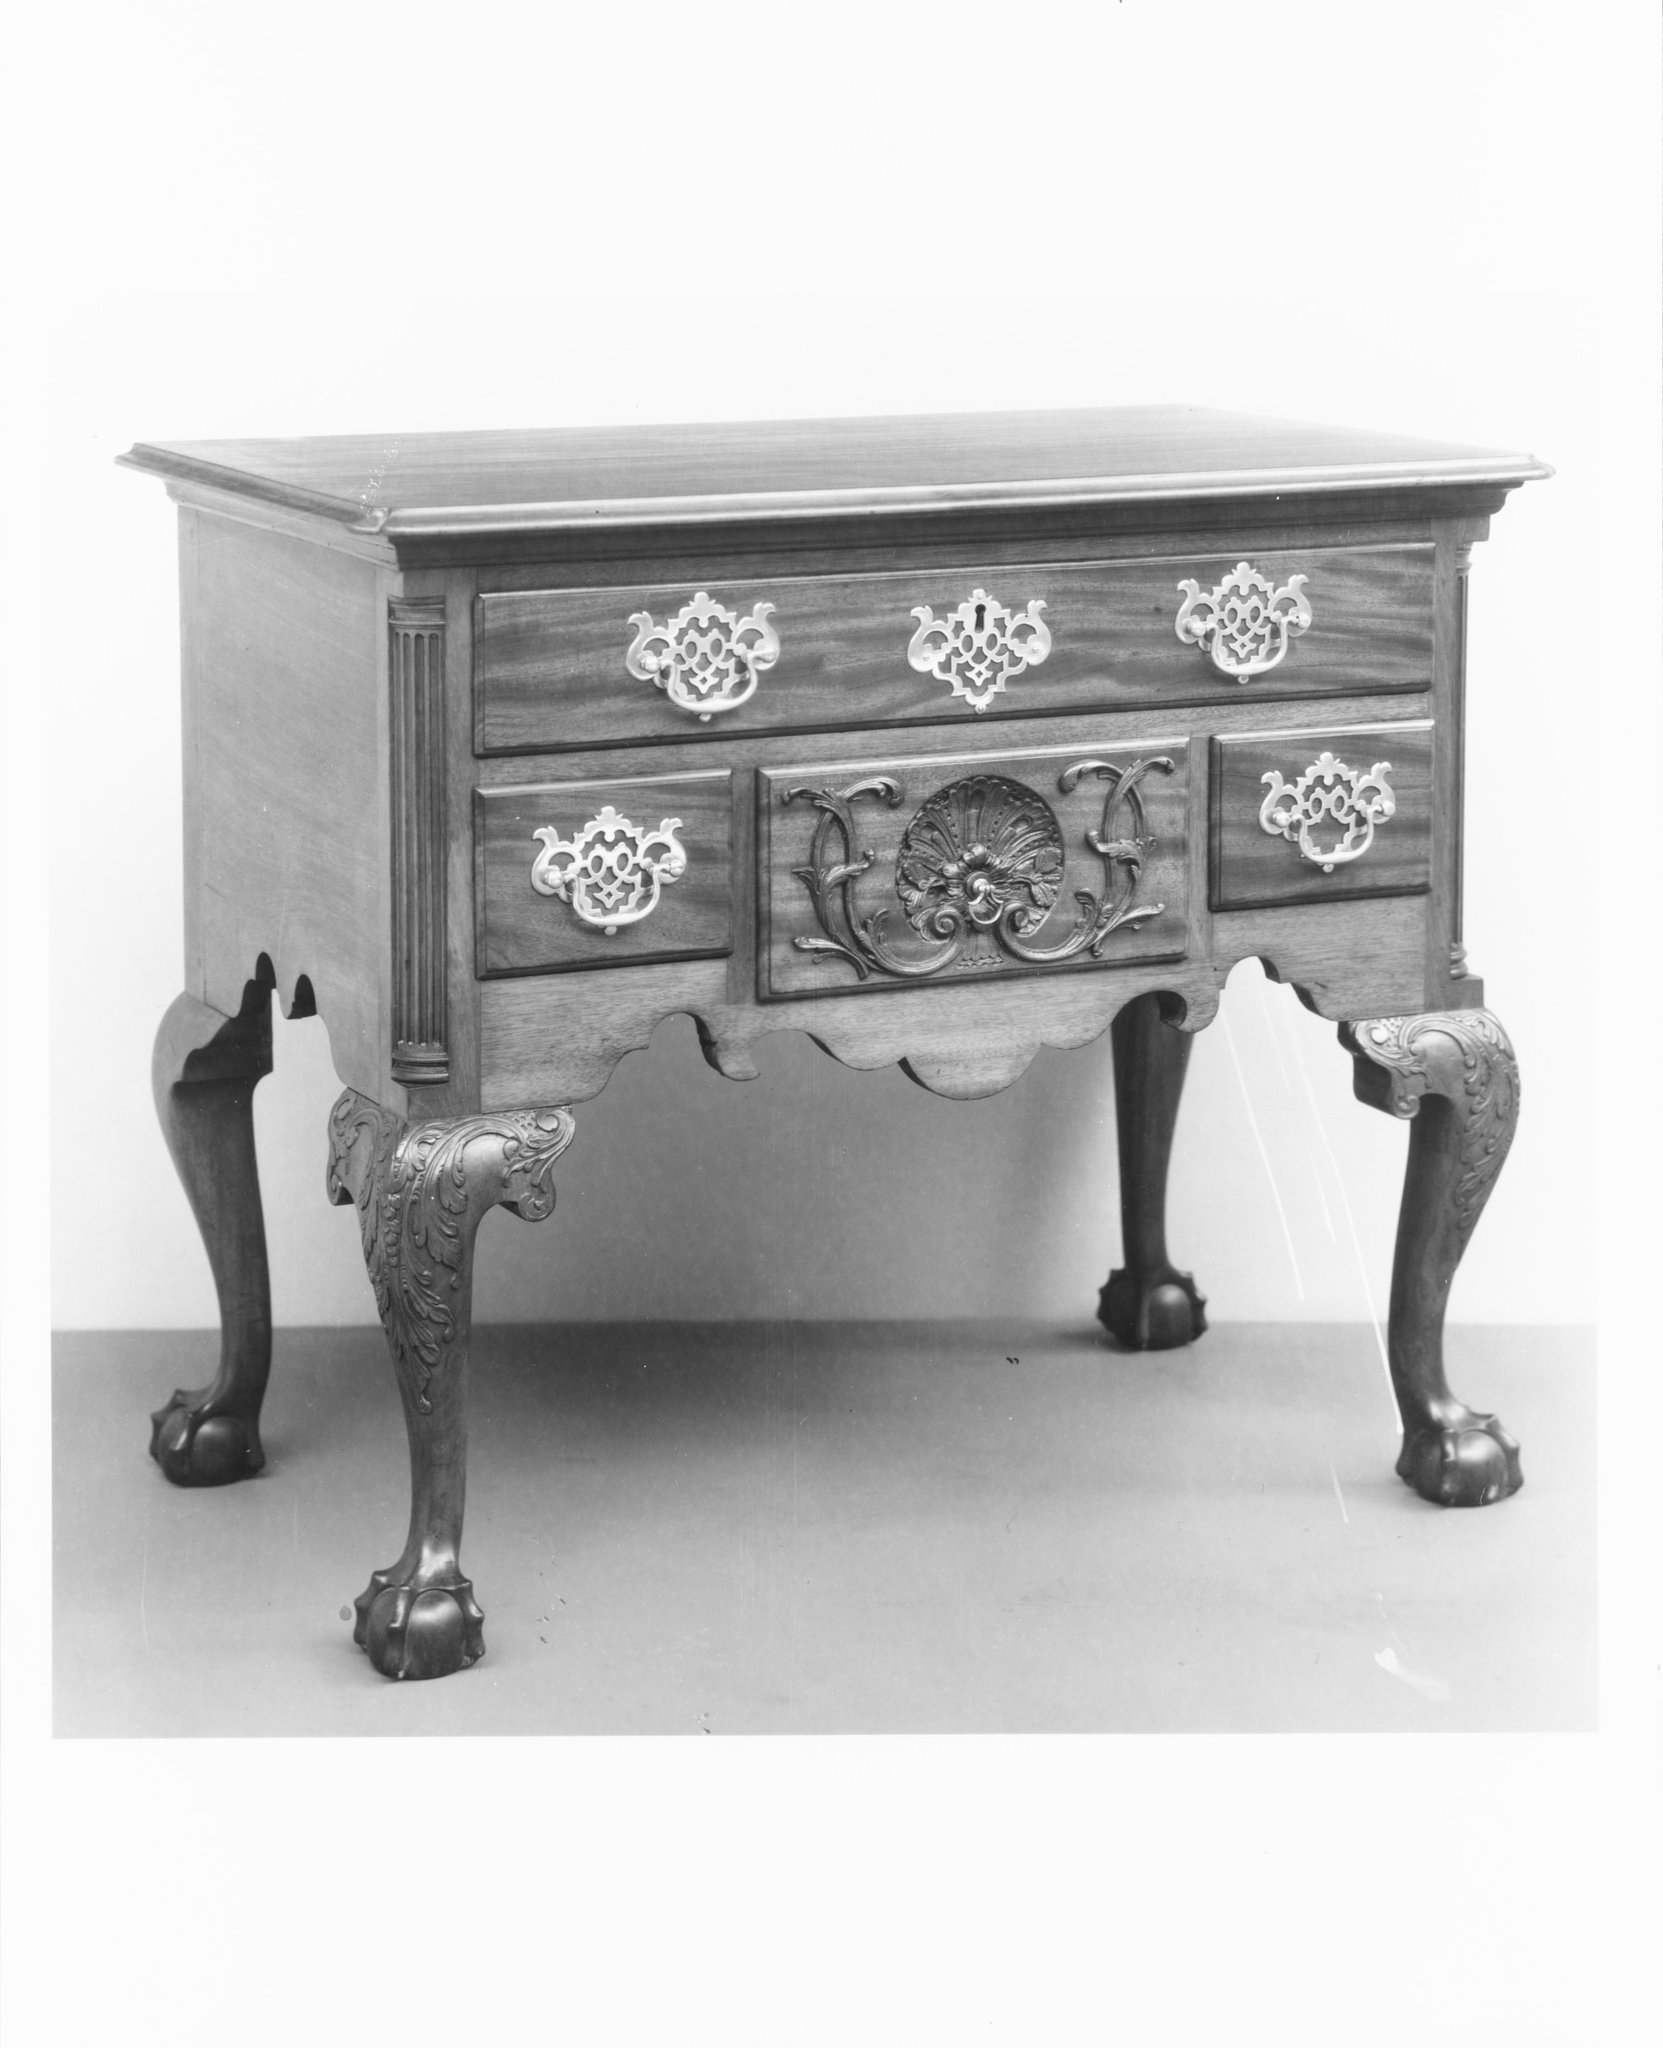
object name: dressing table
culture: american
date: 1755-1790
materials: wood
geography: united states